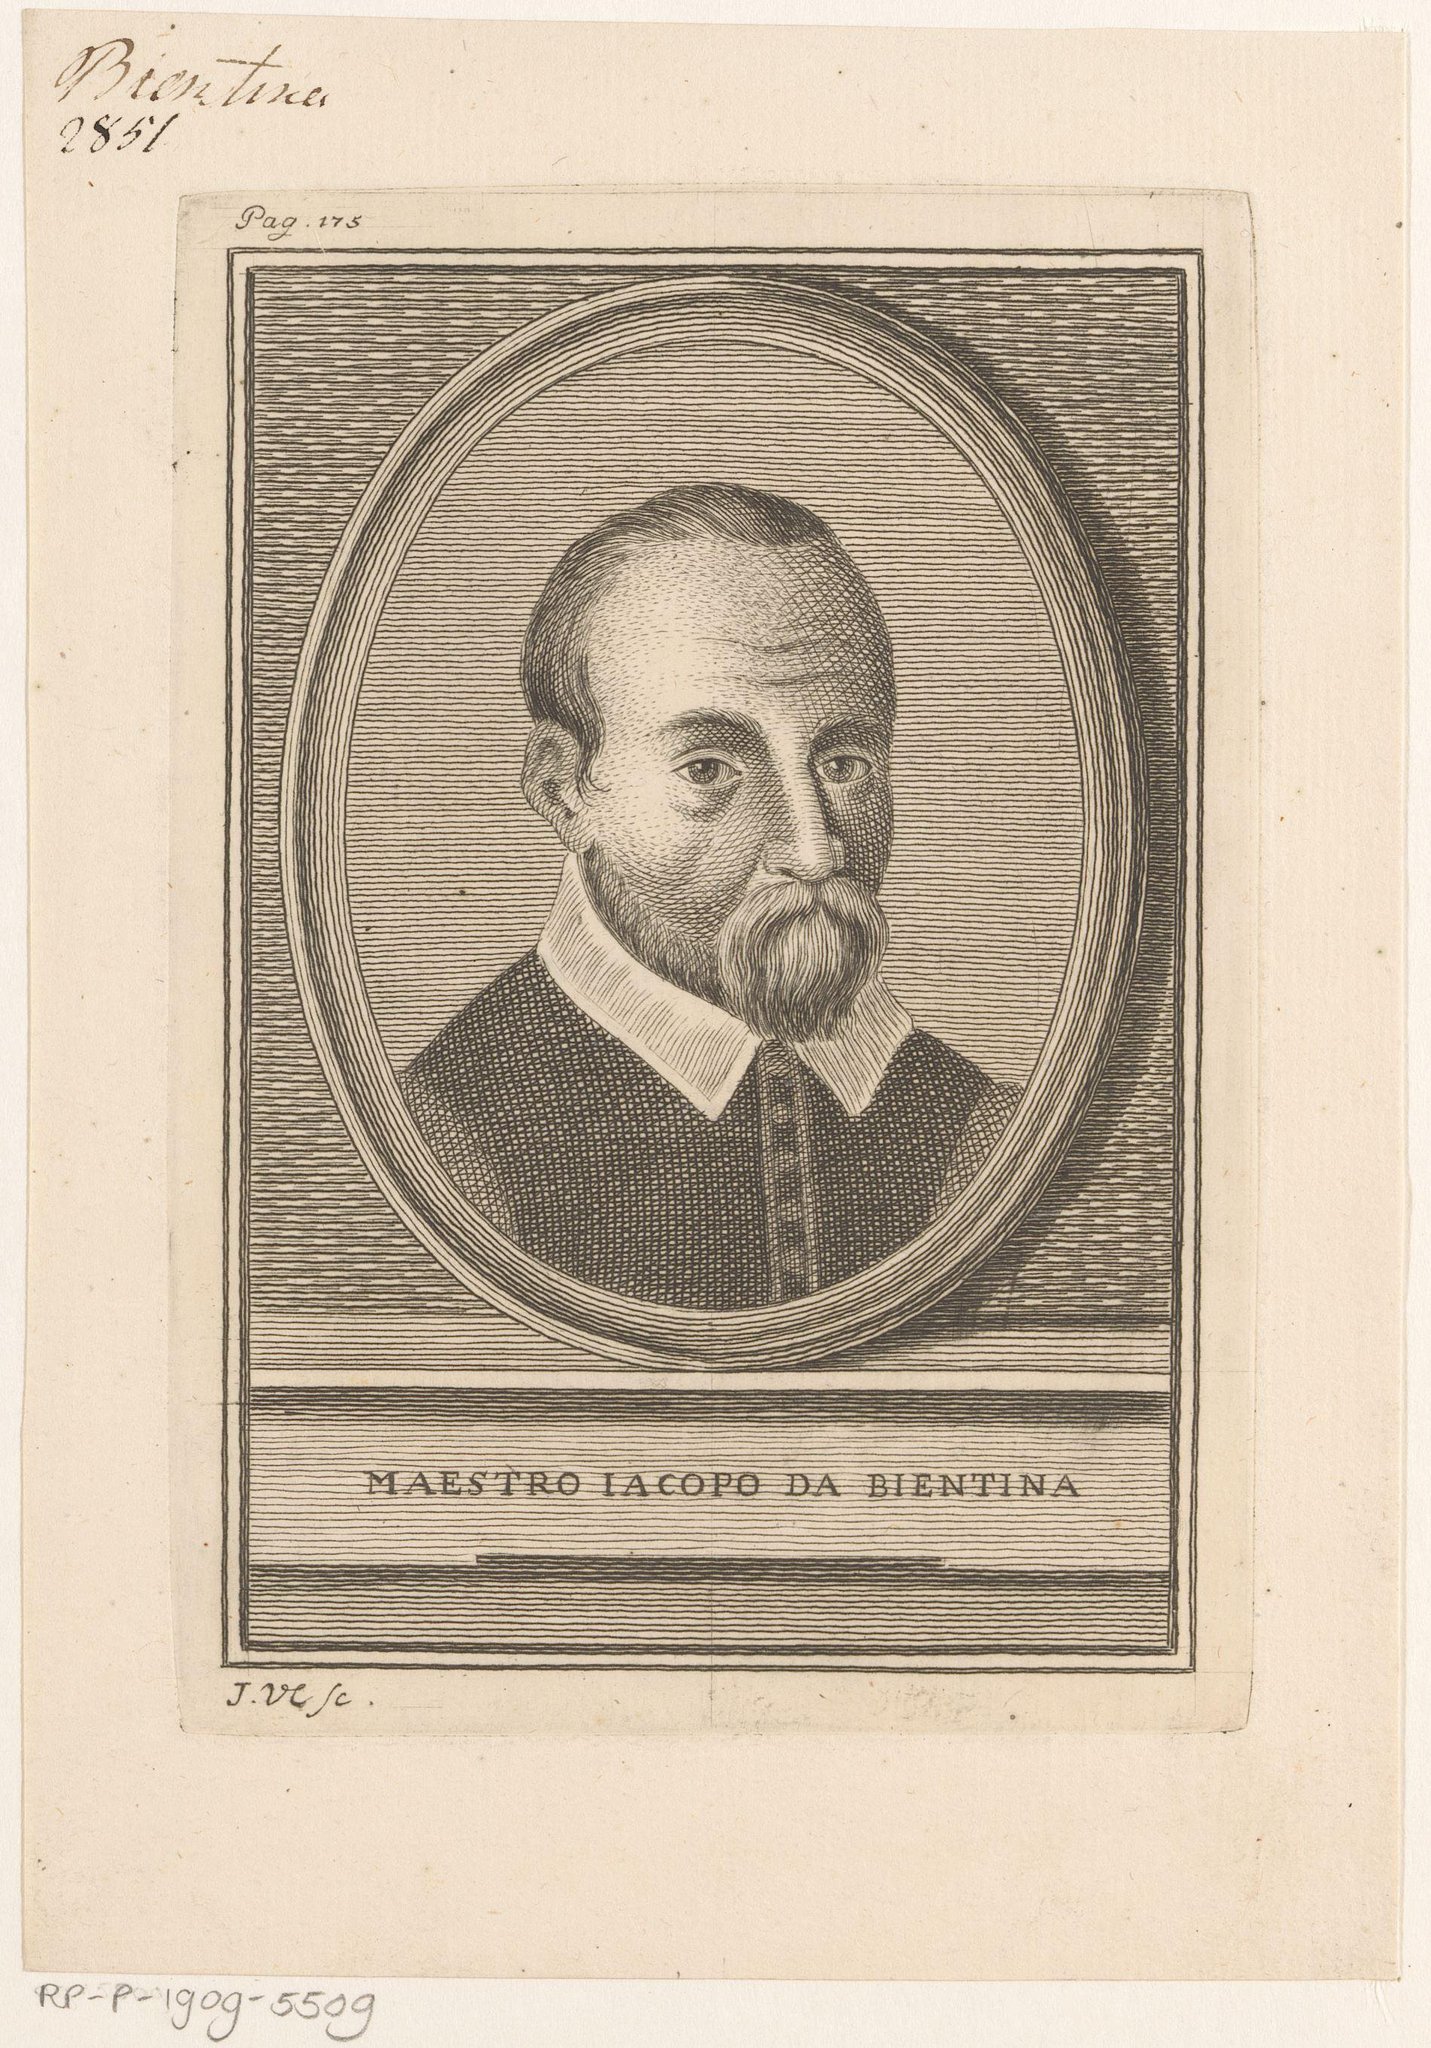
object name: print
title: Portret van liedschrijver Iacopo da Bientina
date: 1750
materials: paper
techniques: engraving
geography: lucca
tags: historical persons, portrait of a writer, barber; surgeon, writer, poet, author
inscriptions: collector's mark: Lugt 2228, inscription: ‘Bientina / 2851’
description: Prent gebruikt voor Grazzini, Anton Francesco. Tutti i trionfi, carri, mascherate o canti carnascialeschi andati per Firenze dal tempo del Magnifico Lorenzo de' Medici fino all' anno 1559 : in questa seconda edizione corretti, con diversi MSS. collazionati, delle loro varie lezioni arricchiti, notabilmente accresciuti, e co' ritratti di ciascun poeta adornate. Lucca: Cosmopoli, 1750.